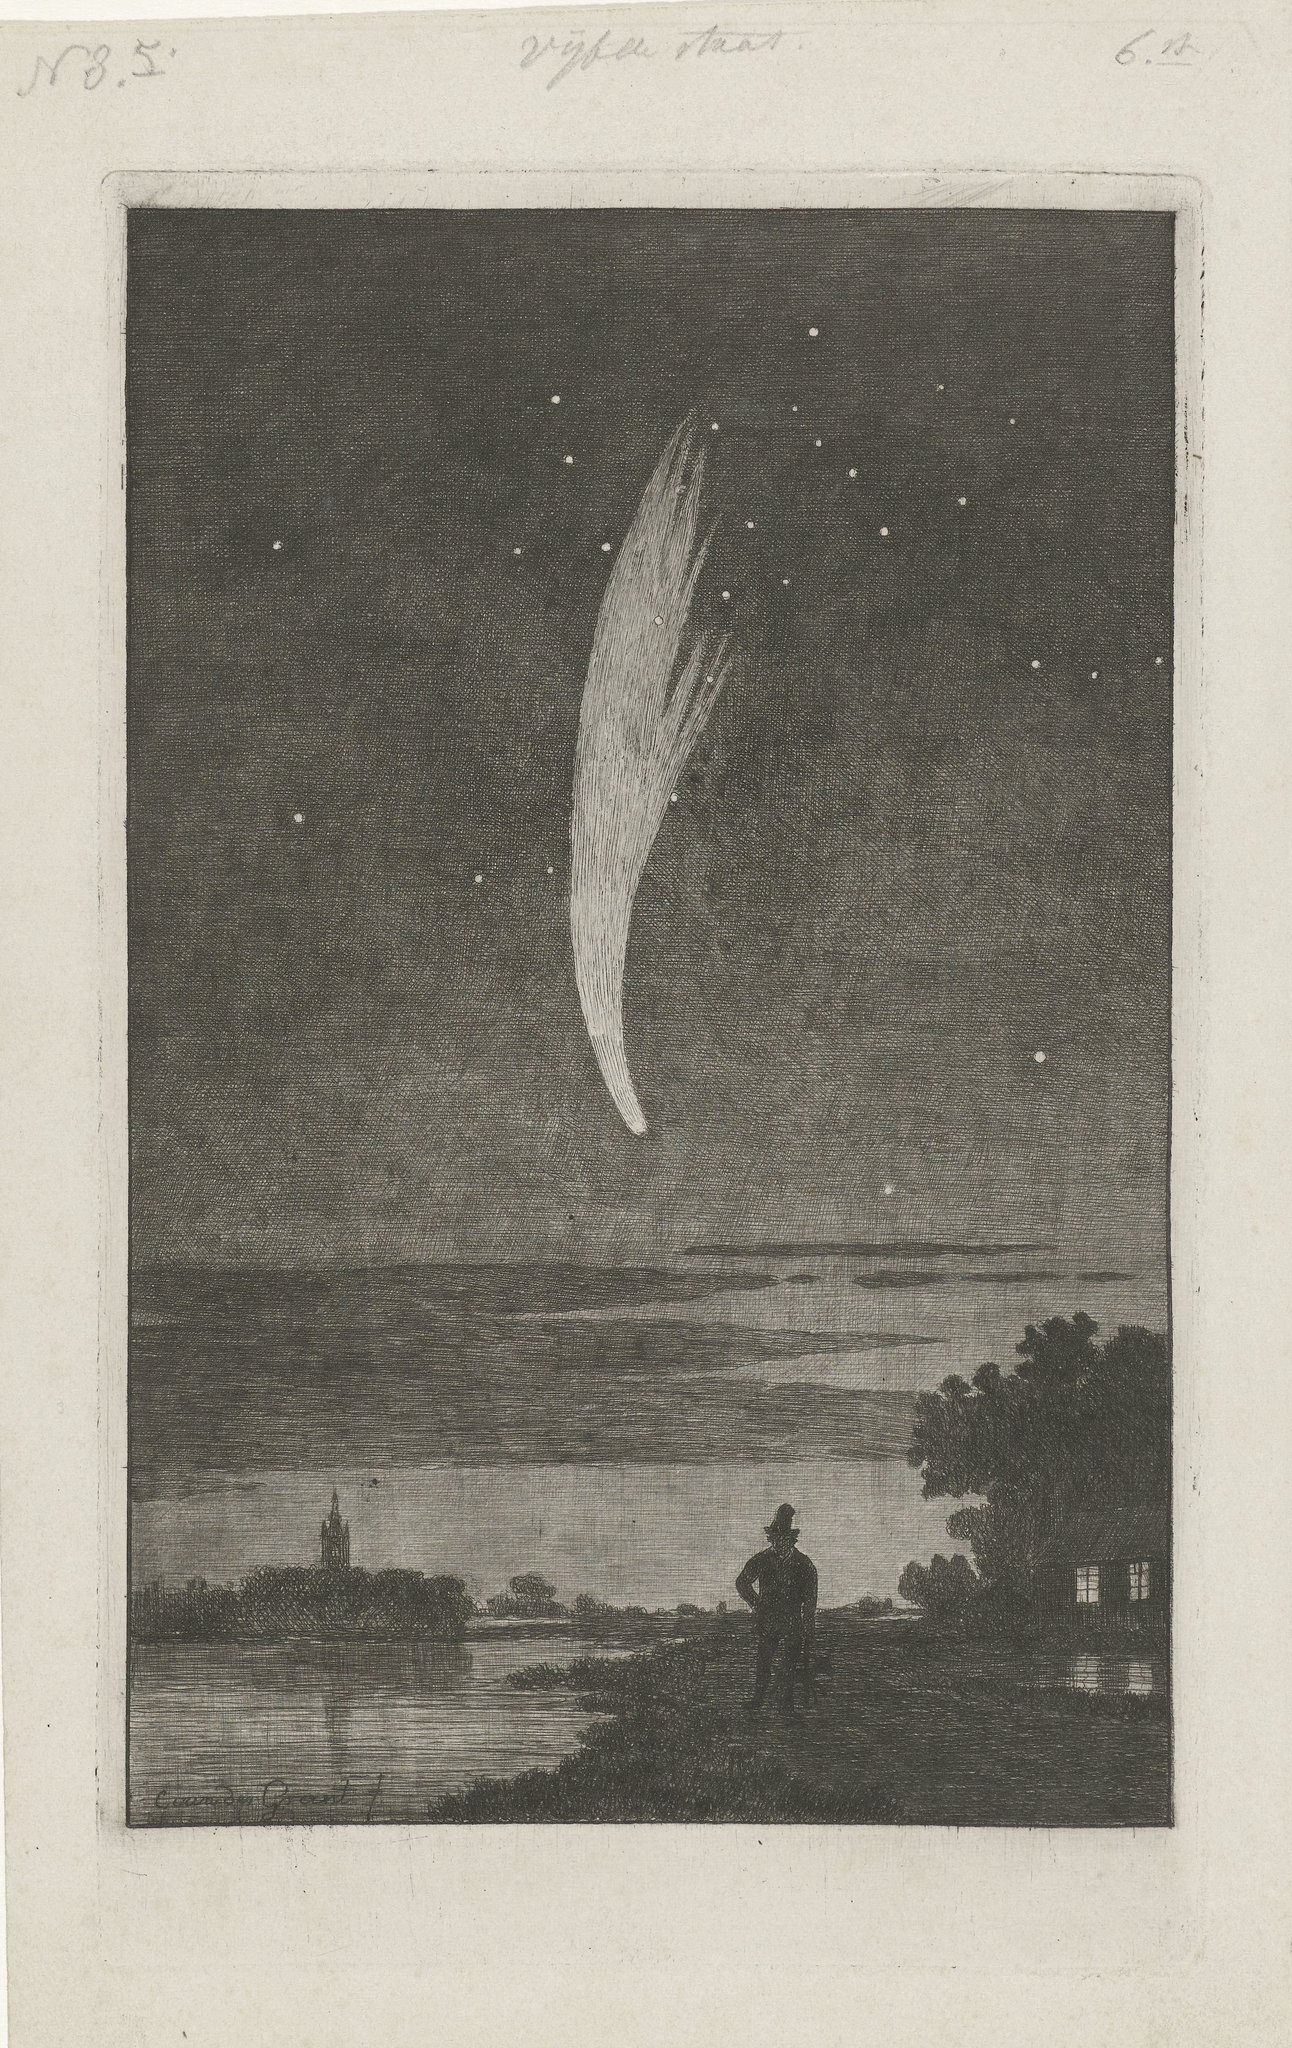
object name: print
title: De komeet van Donati, 1858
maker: cornelis van der griendt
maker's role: draughtsman, painter, print maker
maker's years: 1827-1918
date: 1858-1860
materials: paper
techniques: etching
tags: comet, river (+ landscape with figures, staffage)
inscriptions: collector's mark: Lugt 2228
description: De komeet van Donati, 10 oktober 1858. Op de voorgrond een man met hond bij een rivier. Op de achtergrond links een kerktoren.